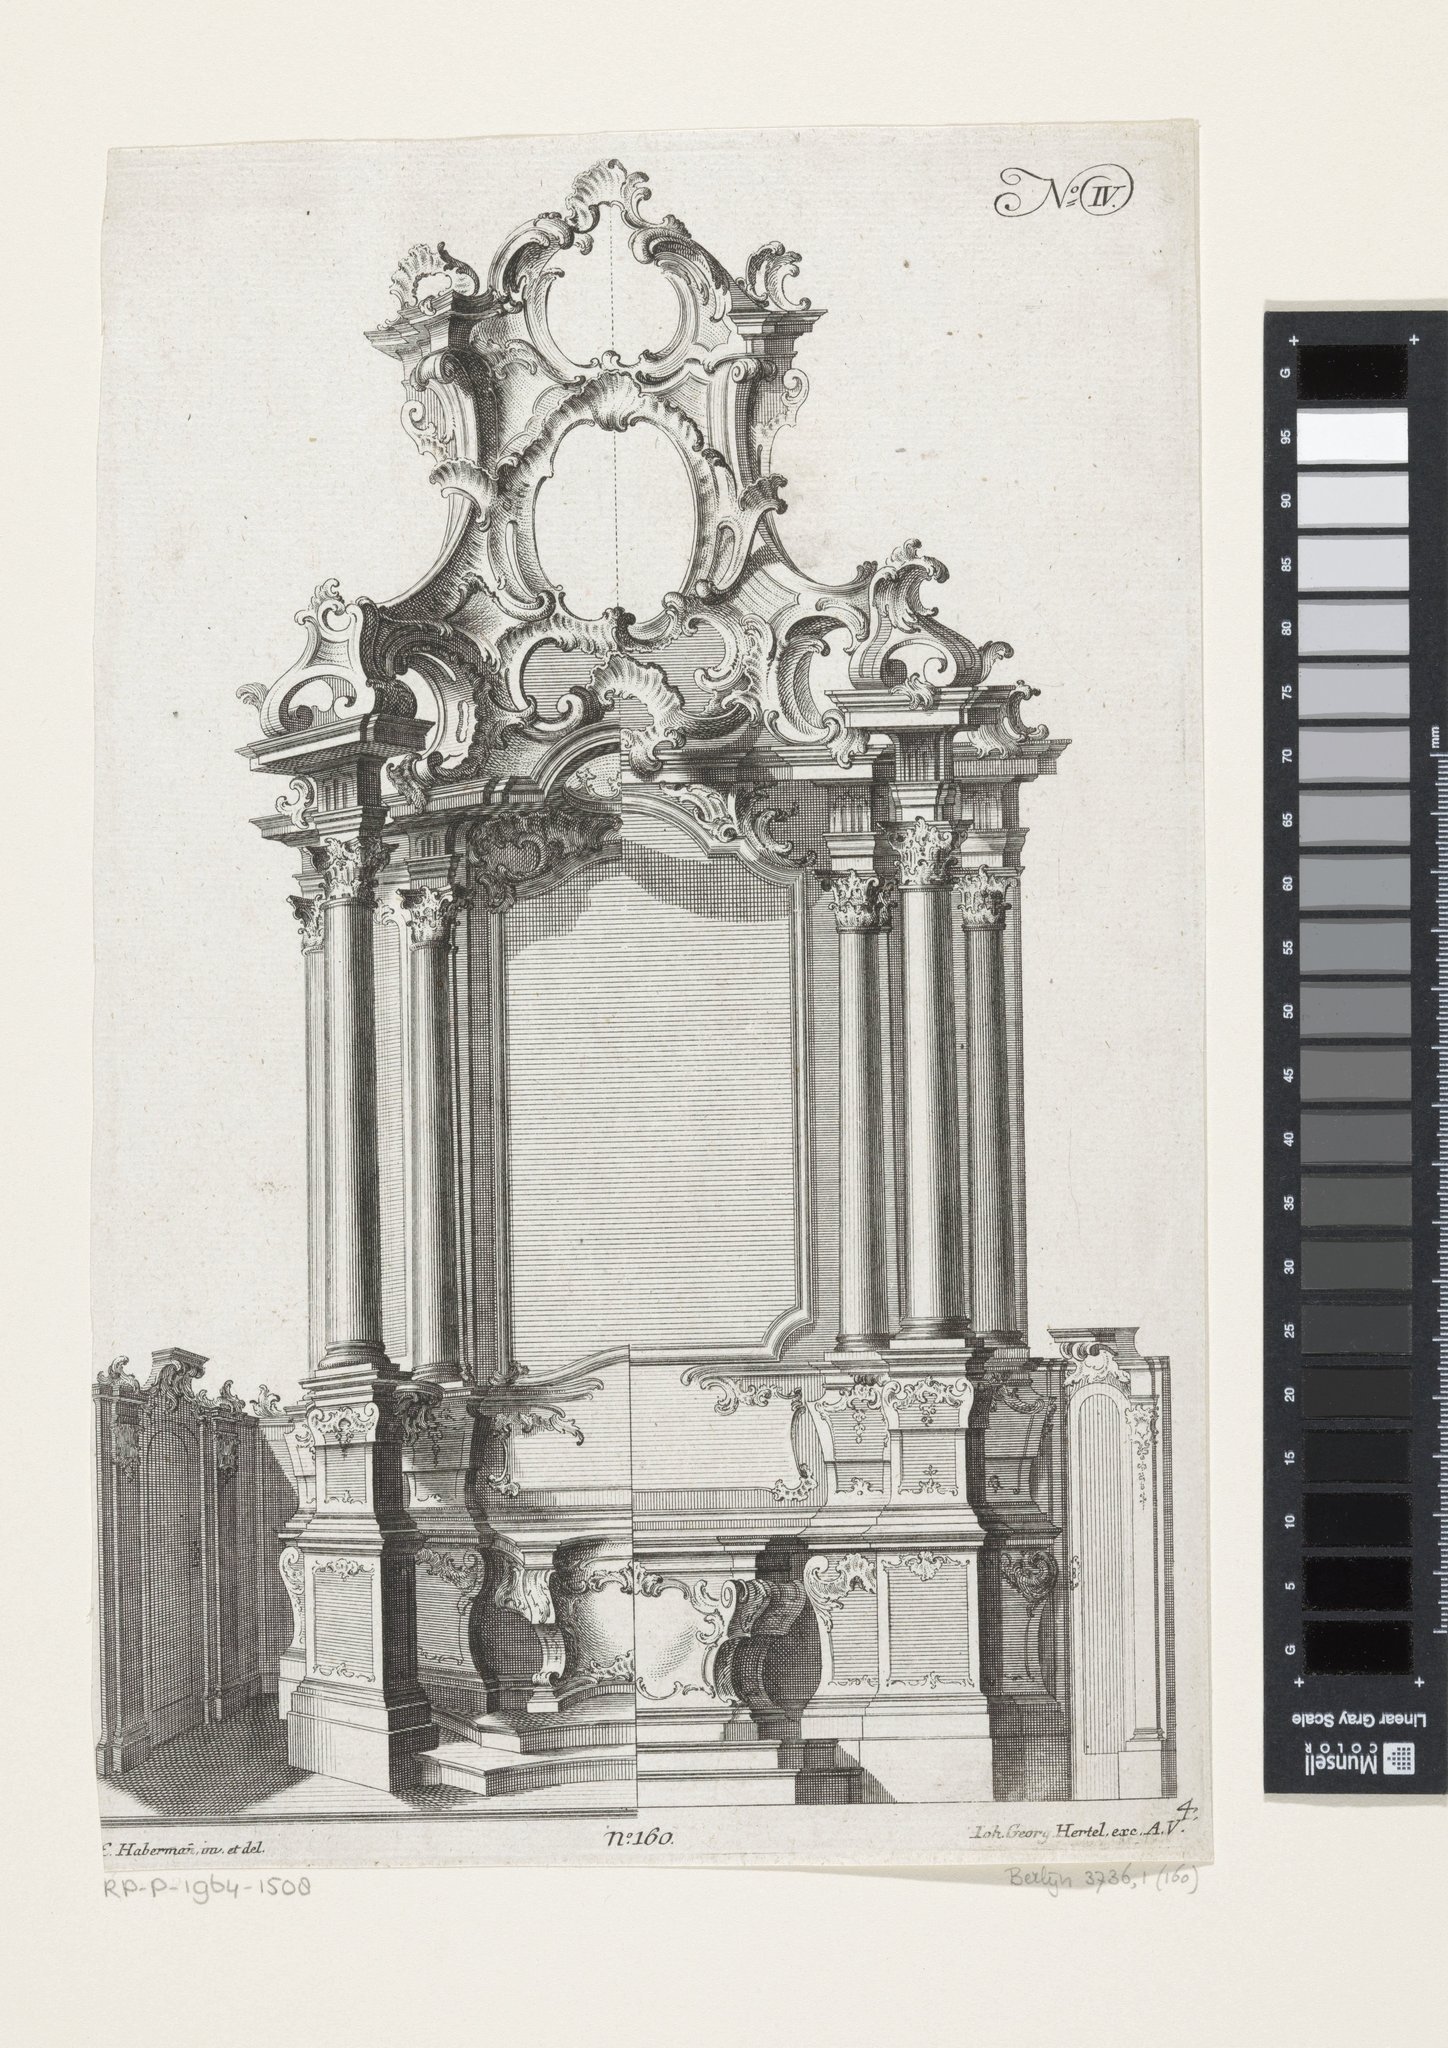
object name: print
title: Altaar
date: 1731-1775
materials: paper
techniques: engraving, etching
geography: augsburg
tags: rocaille ornament, altar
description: Altaar met rocaille ornamenten. Uitgeversnummer 160.